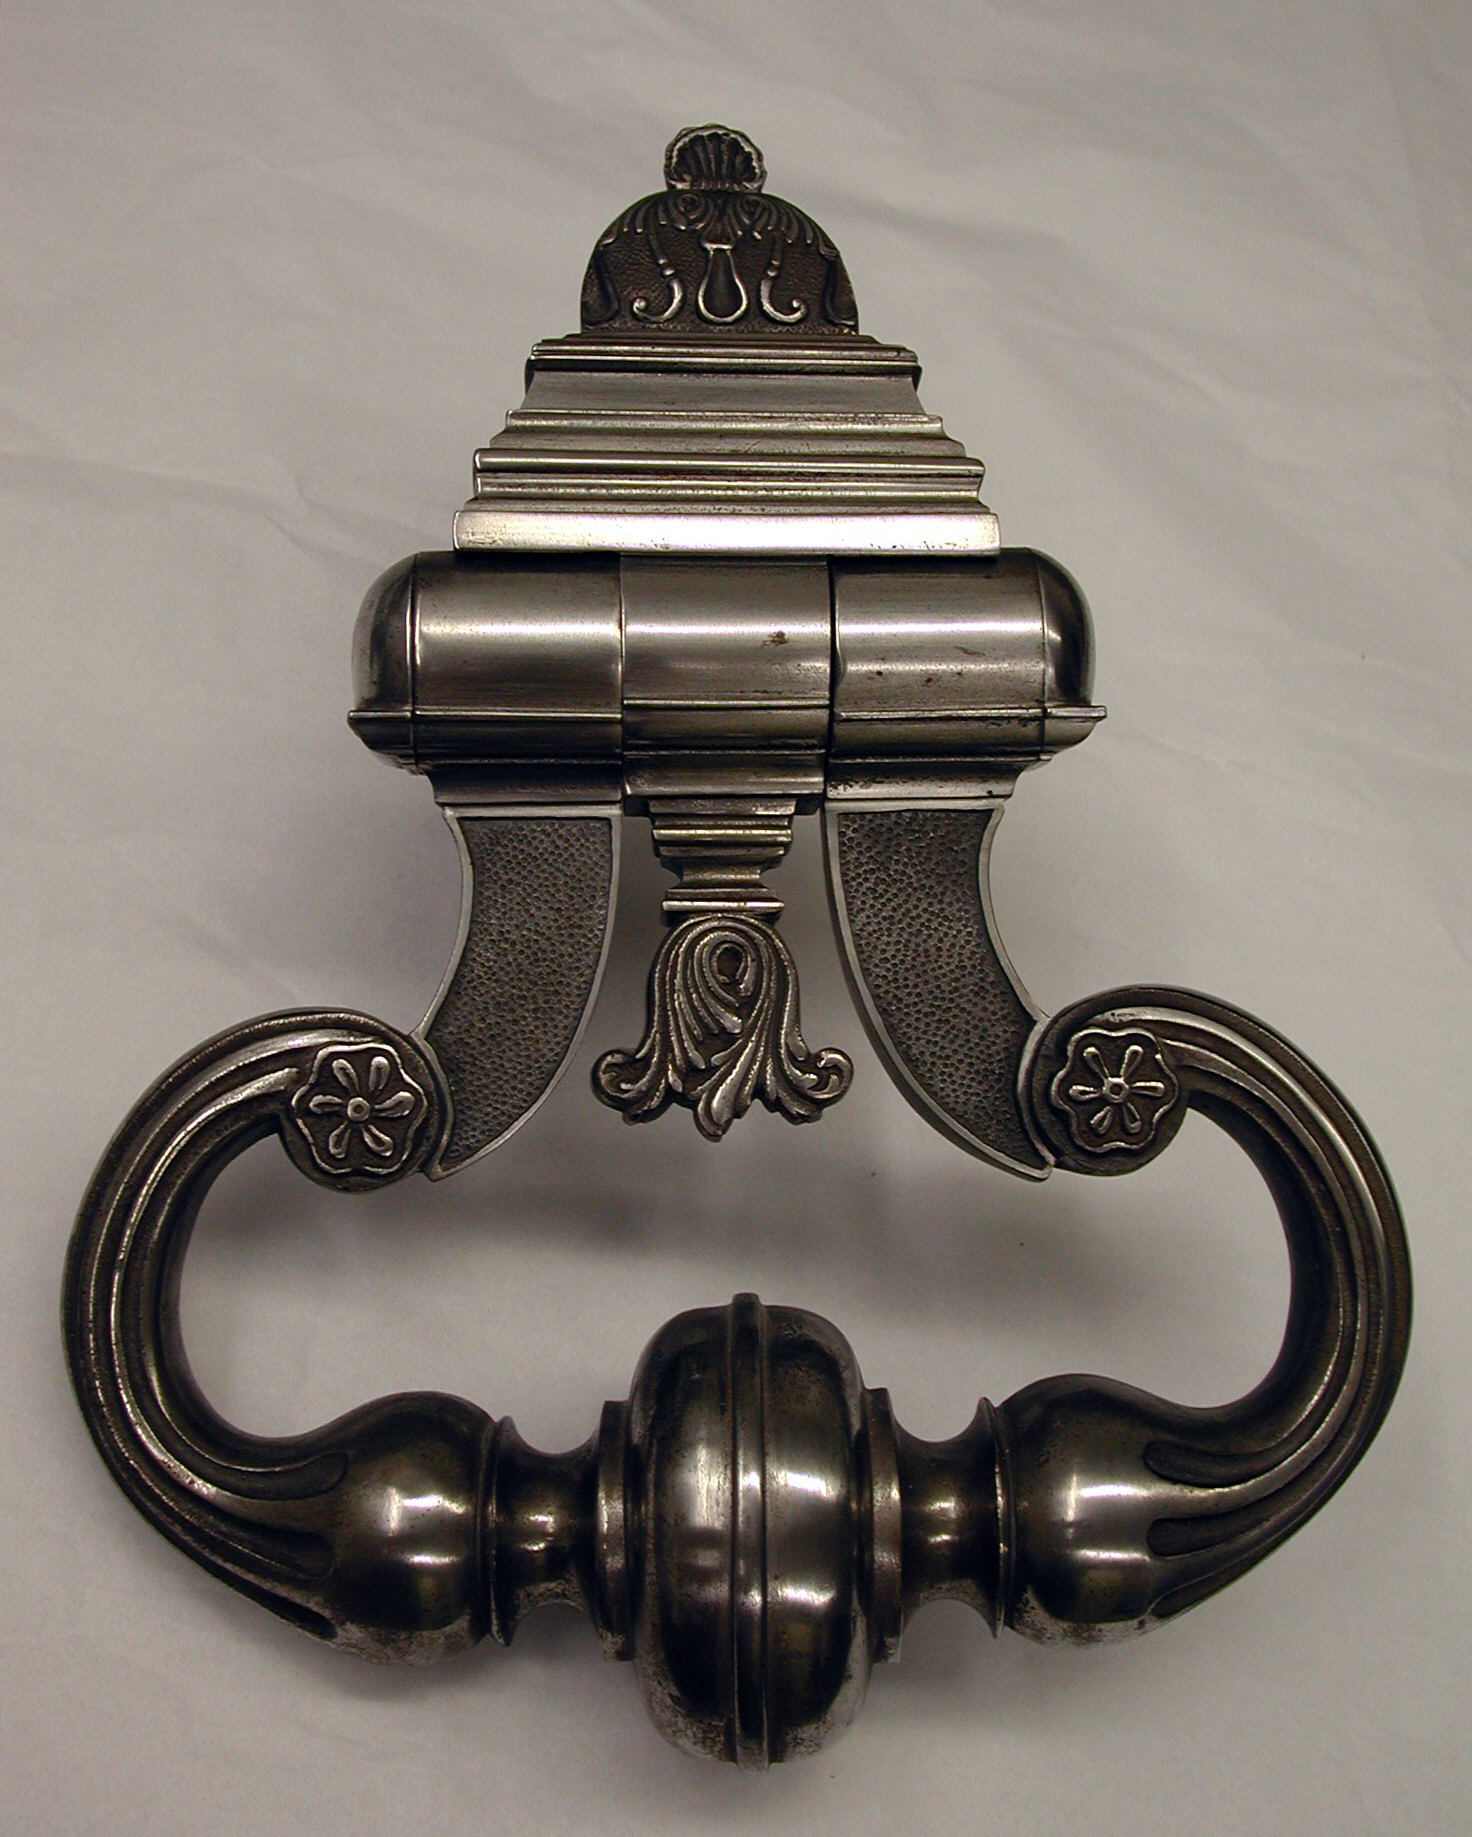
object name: door knocker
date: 1701-1800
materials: iron